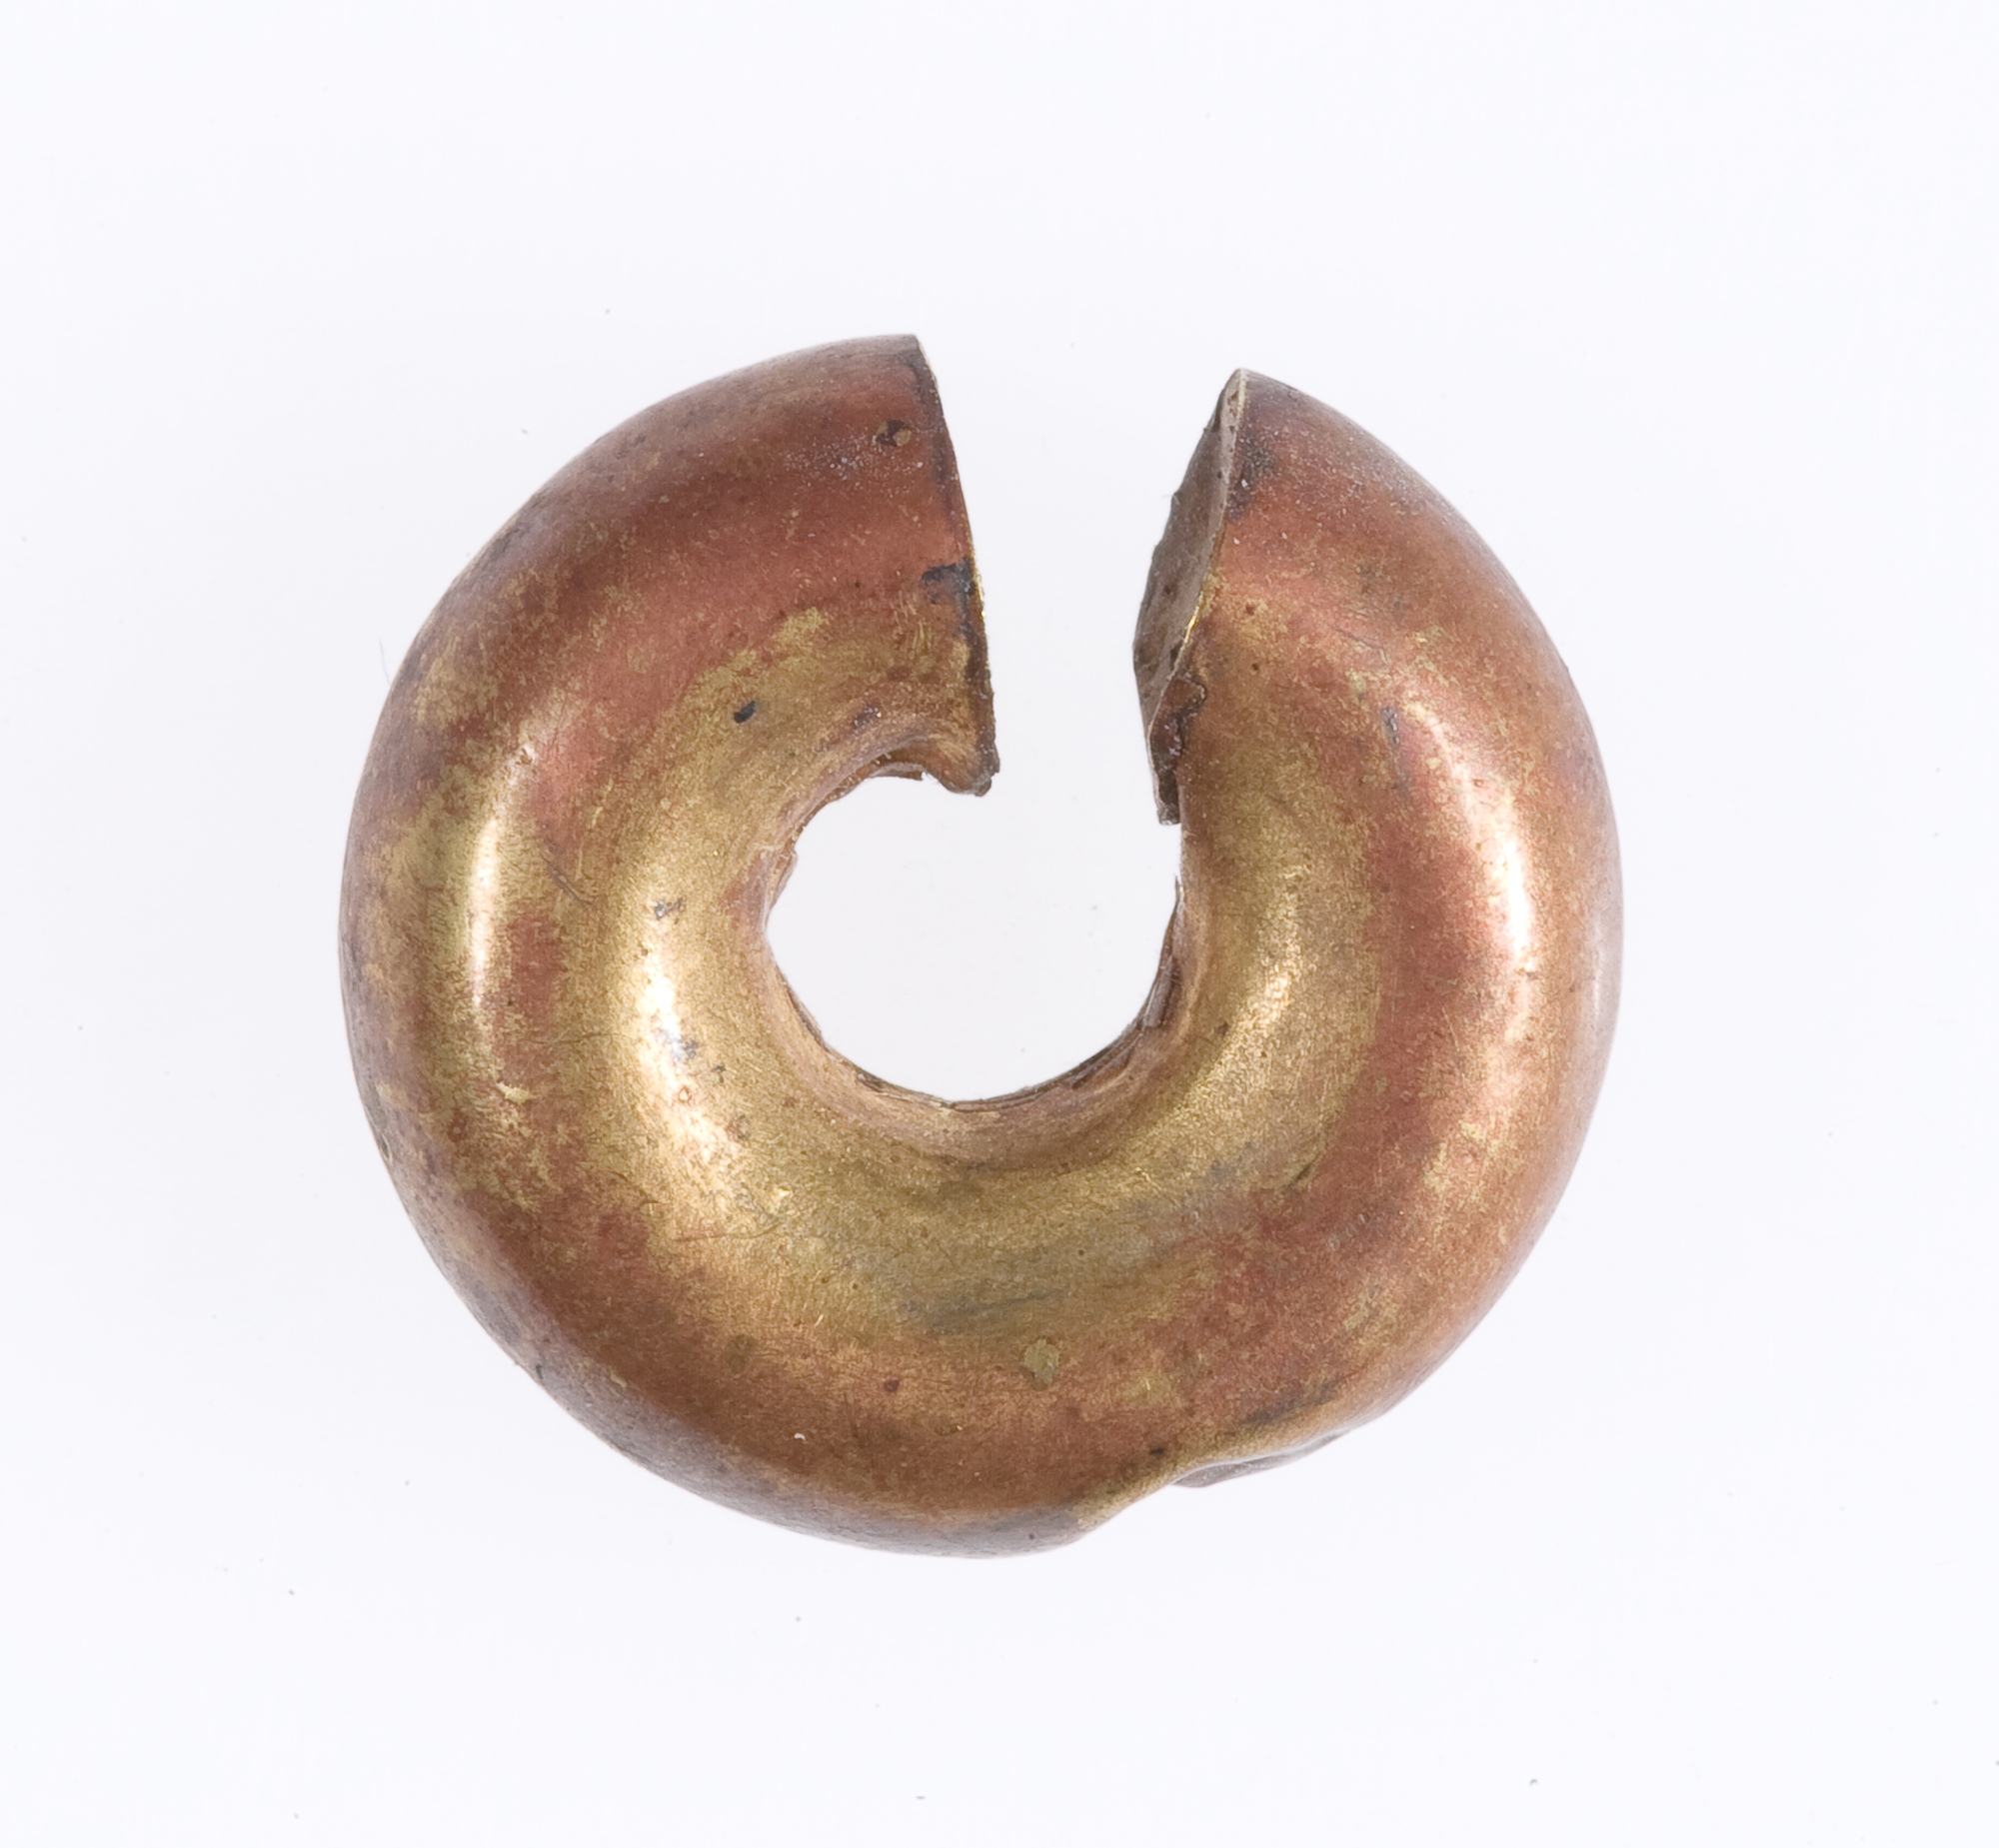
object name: earring, penannular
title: Penannular Earring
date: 1550-1425 BCE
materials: gold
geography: egypt